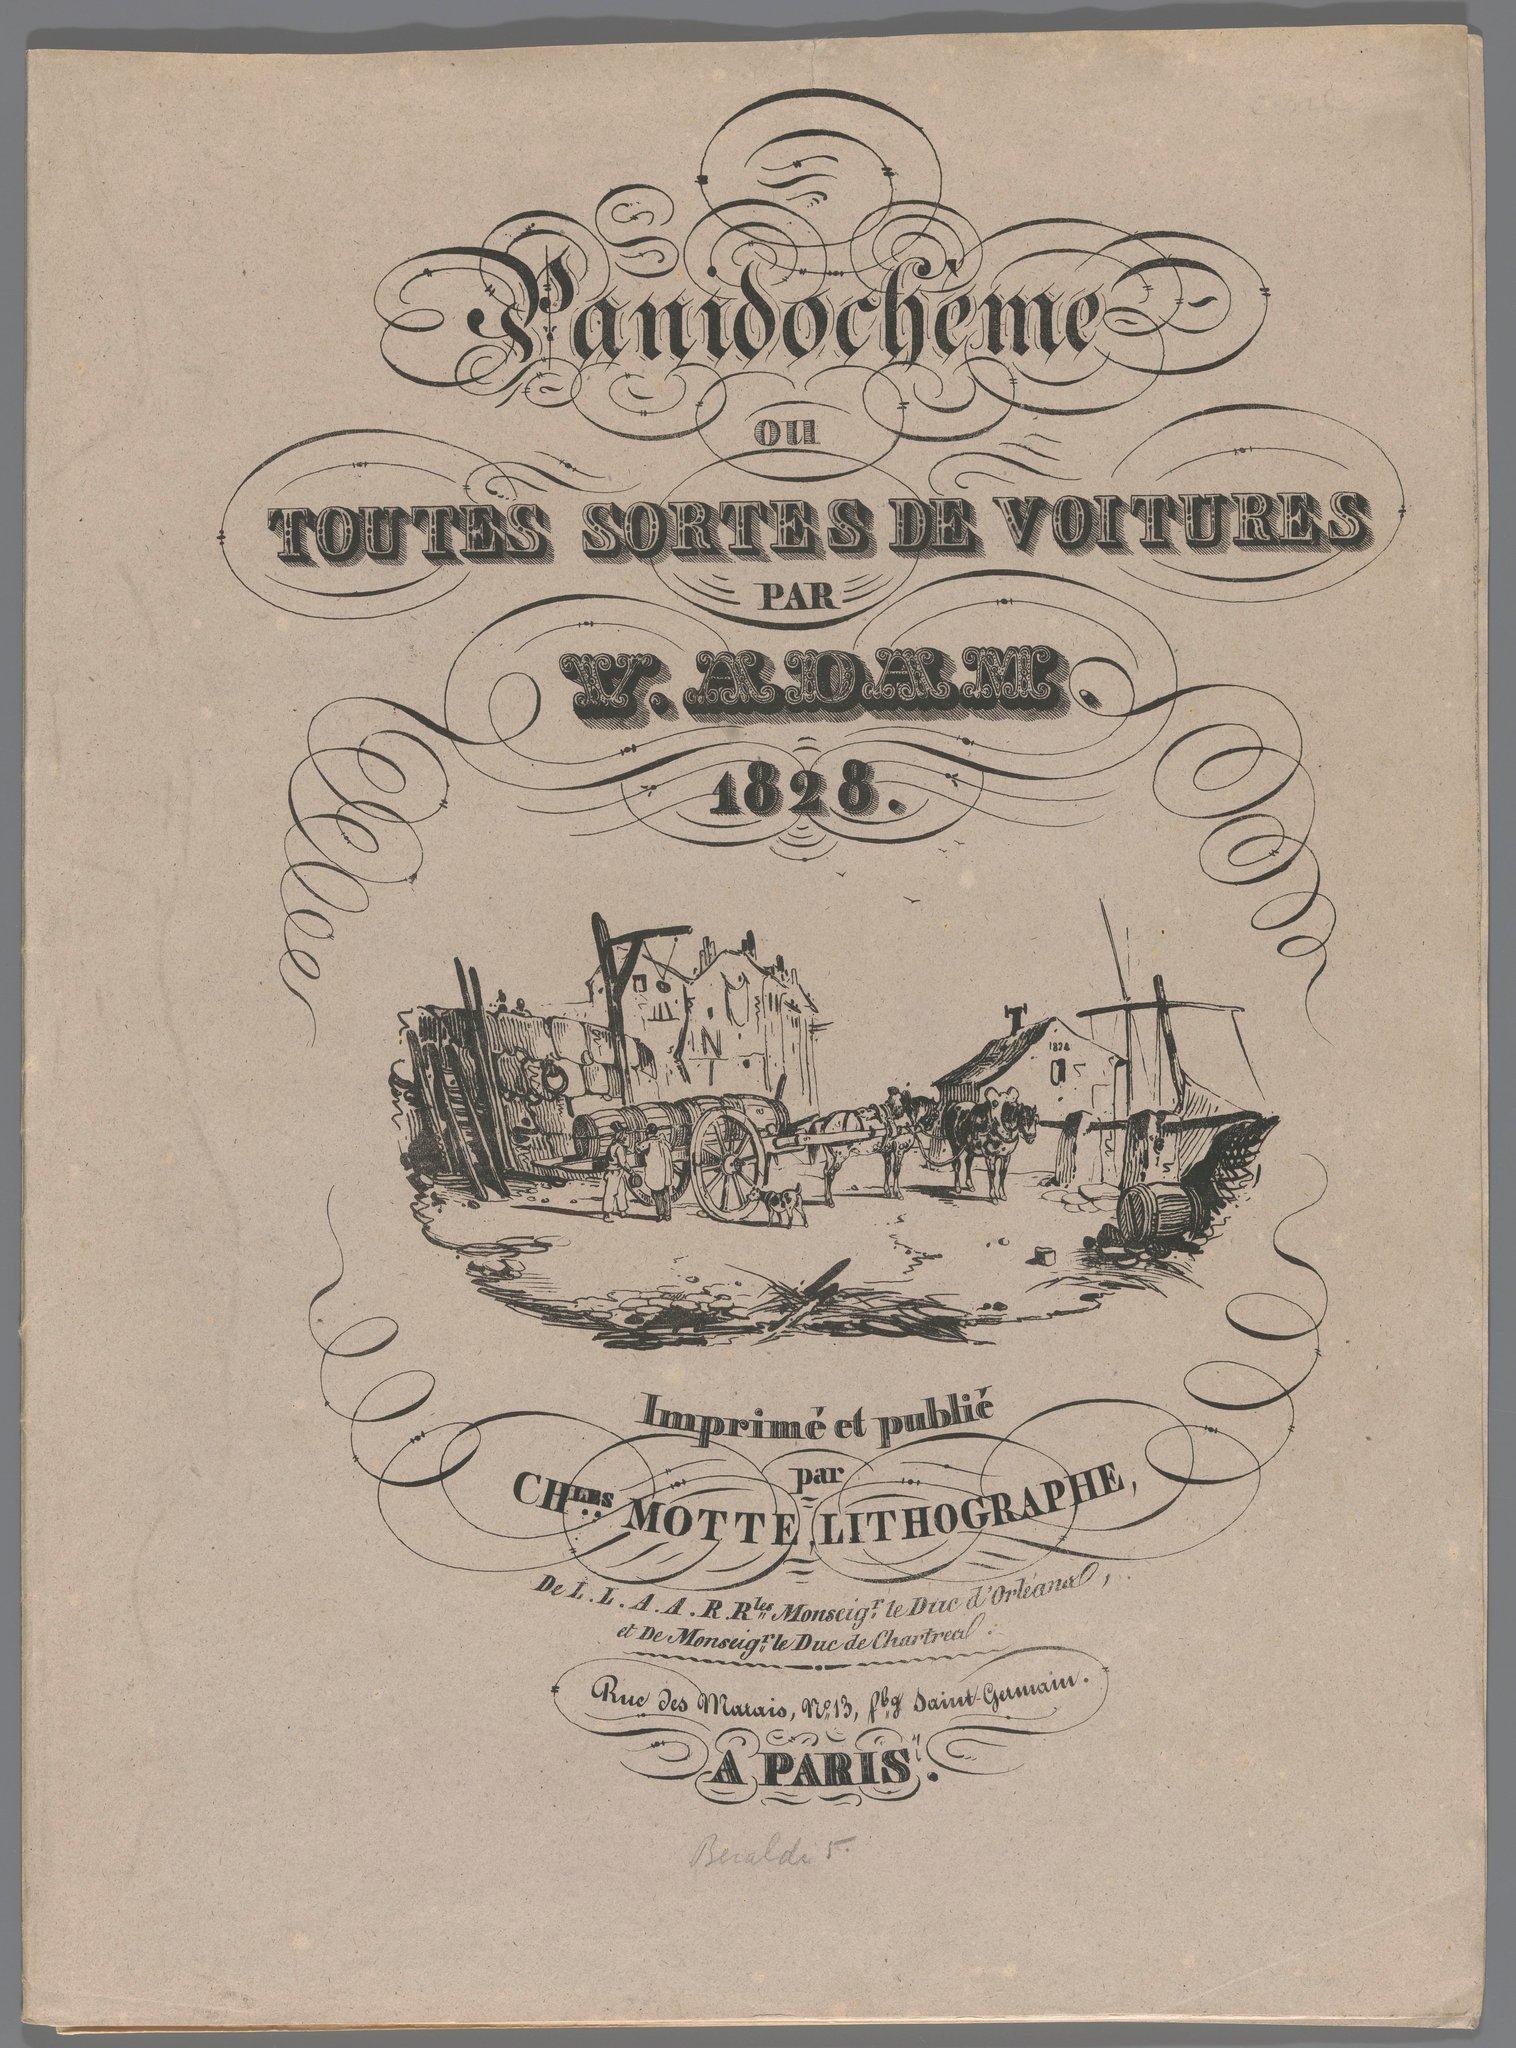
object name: wrapper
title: Panidochème ou toutes sortes de voitures (2)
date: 1828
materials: paper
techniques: pen lithography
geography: paris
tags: animal traction, animal-drawn vehicle (carriage etc.)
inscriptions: collector's mark: Lugt 2228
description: De prentserie waar deze omslag deel van uitmaakt werd in drie delen van twaalf prenten vanaf 1827 tot en met 1830 gepubliceerd. Elk van de drie delen werd voorzien van een aparte omslag. In deze omslag bevinden zich de prenten genummerd 13 tot en met 24.